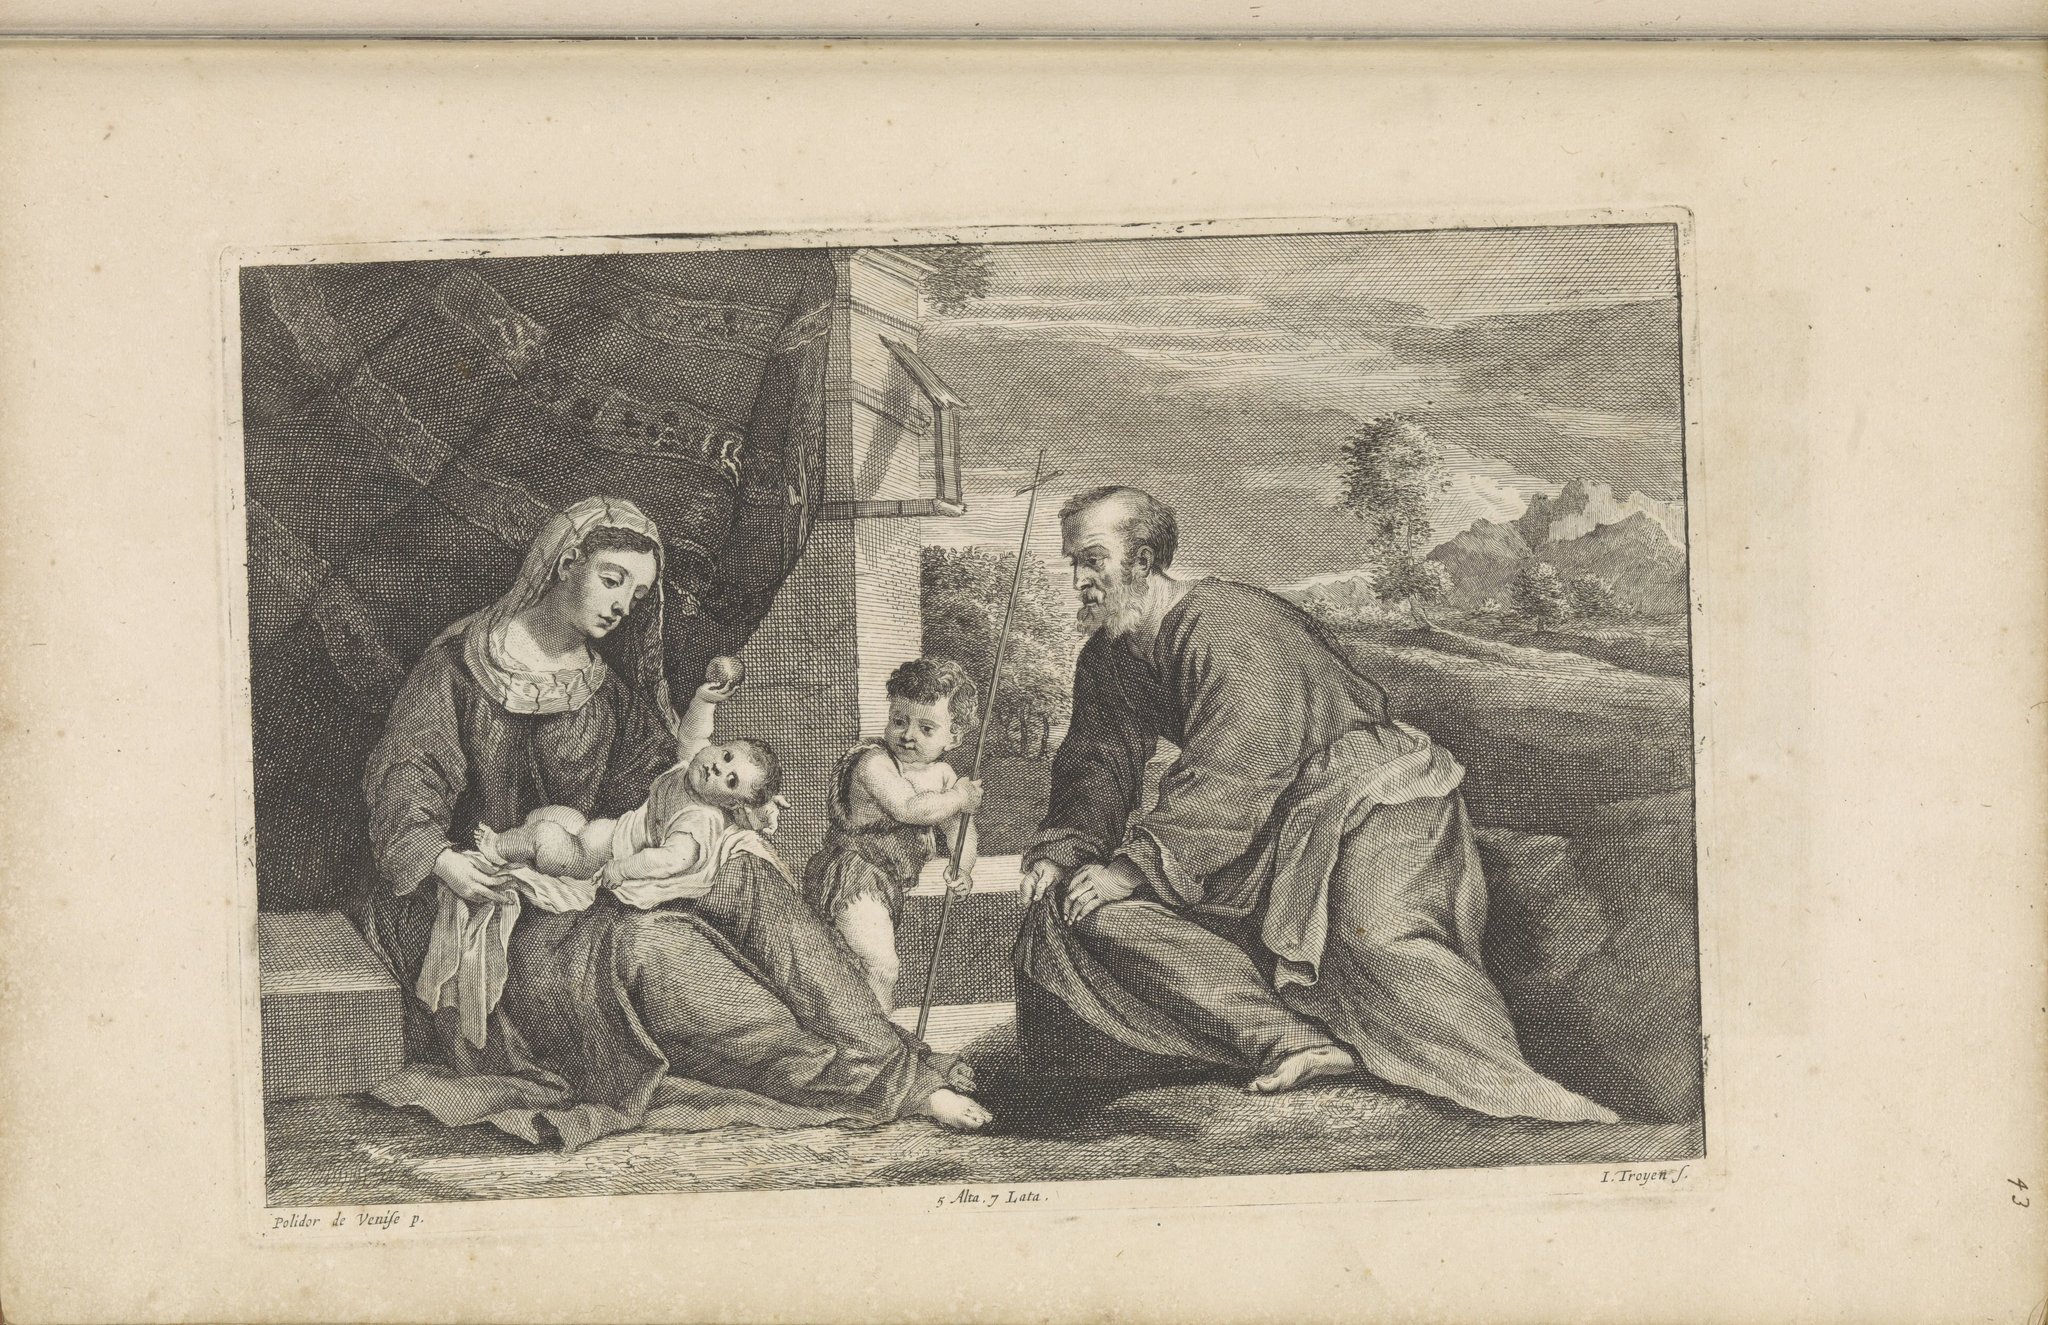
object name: album leaf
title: Heilige Familie met Johannes de Doper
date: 1660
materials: paper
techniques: engraving, etching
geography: southern netherlands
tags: holy family with john the baptist (as child), landscapes in the temperate zone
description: David Teniers heeft waarschijnlijk van alle schilderijen uit de collectie van Leopold Willem van Oostenrijk een olieverfstudie op doek of paneel vervaardigd (zgn. pasticcio), die als voorbeeld voor de prentmakers diende. Het is niet altijd duidelijk of de pasticci door hem zijn gemaakt of door zijn atelier. Niet alle pasticci zijn overgeleverd.